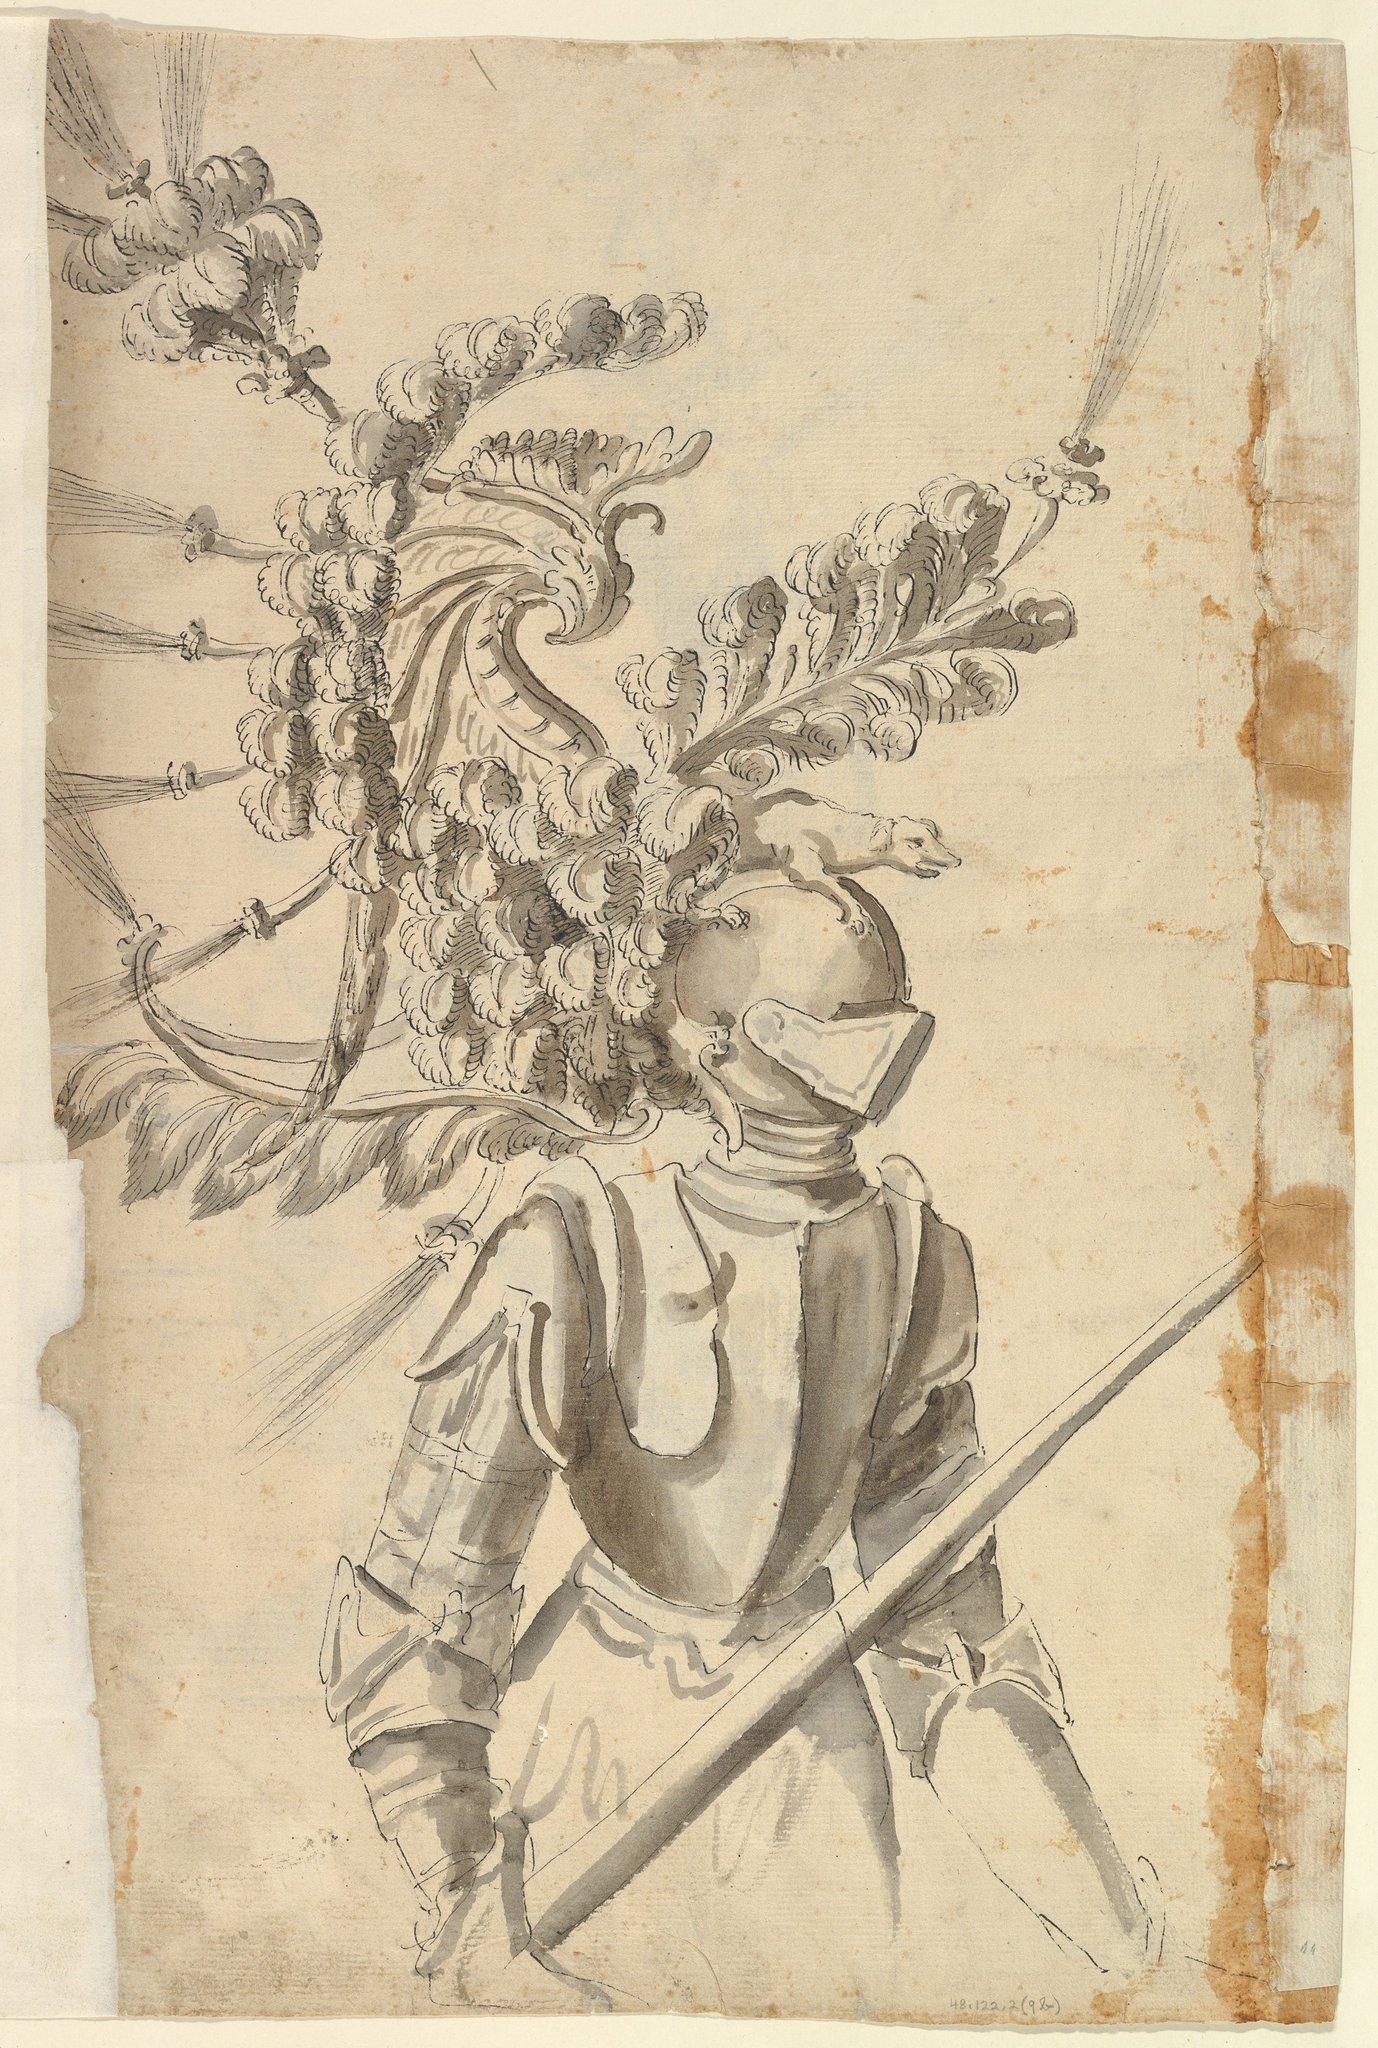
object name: collection ornament architecture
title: Design for an Armor with Tournament Headdress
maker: baccio del bianco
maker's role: artist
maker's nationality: italian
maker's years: 1604-1656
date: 1620-1656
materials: ink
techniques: wash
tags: armor,military clothing